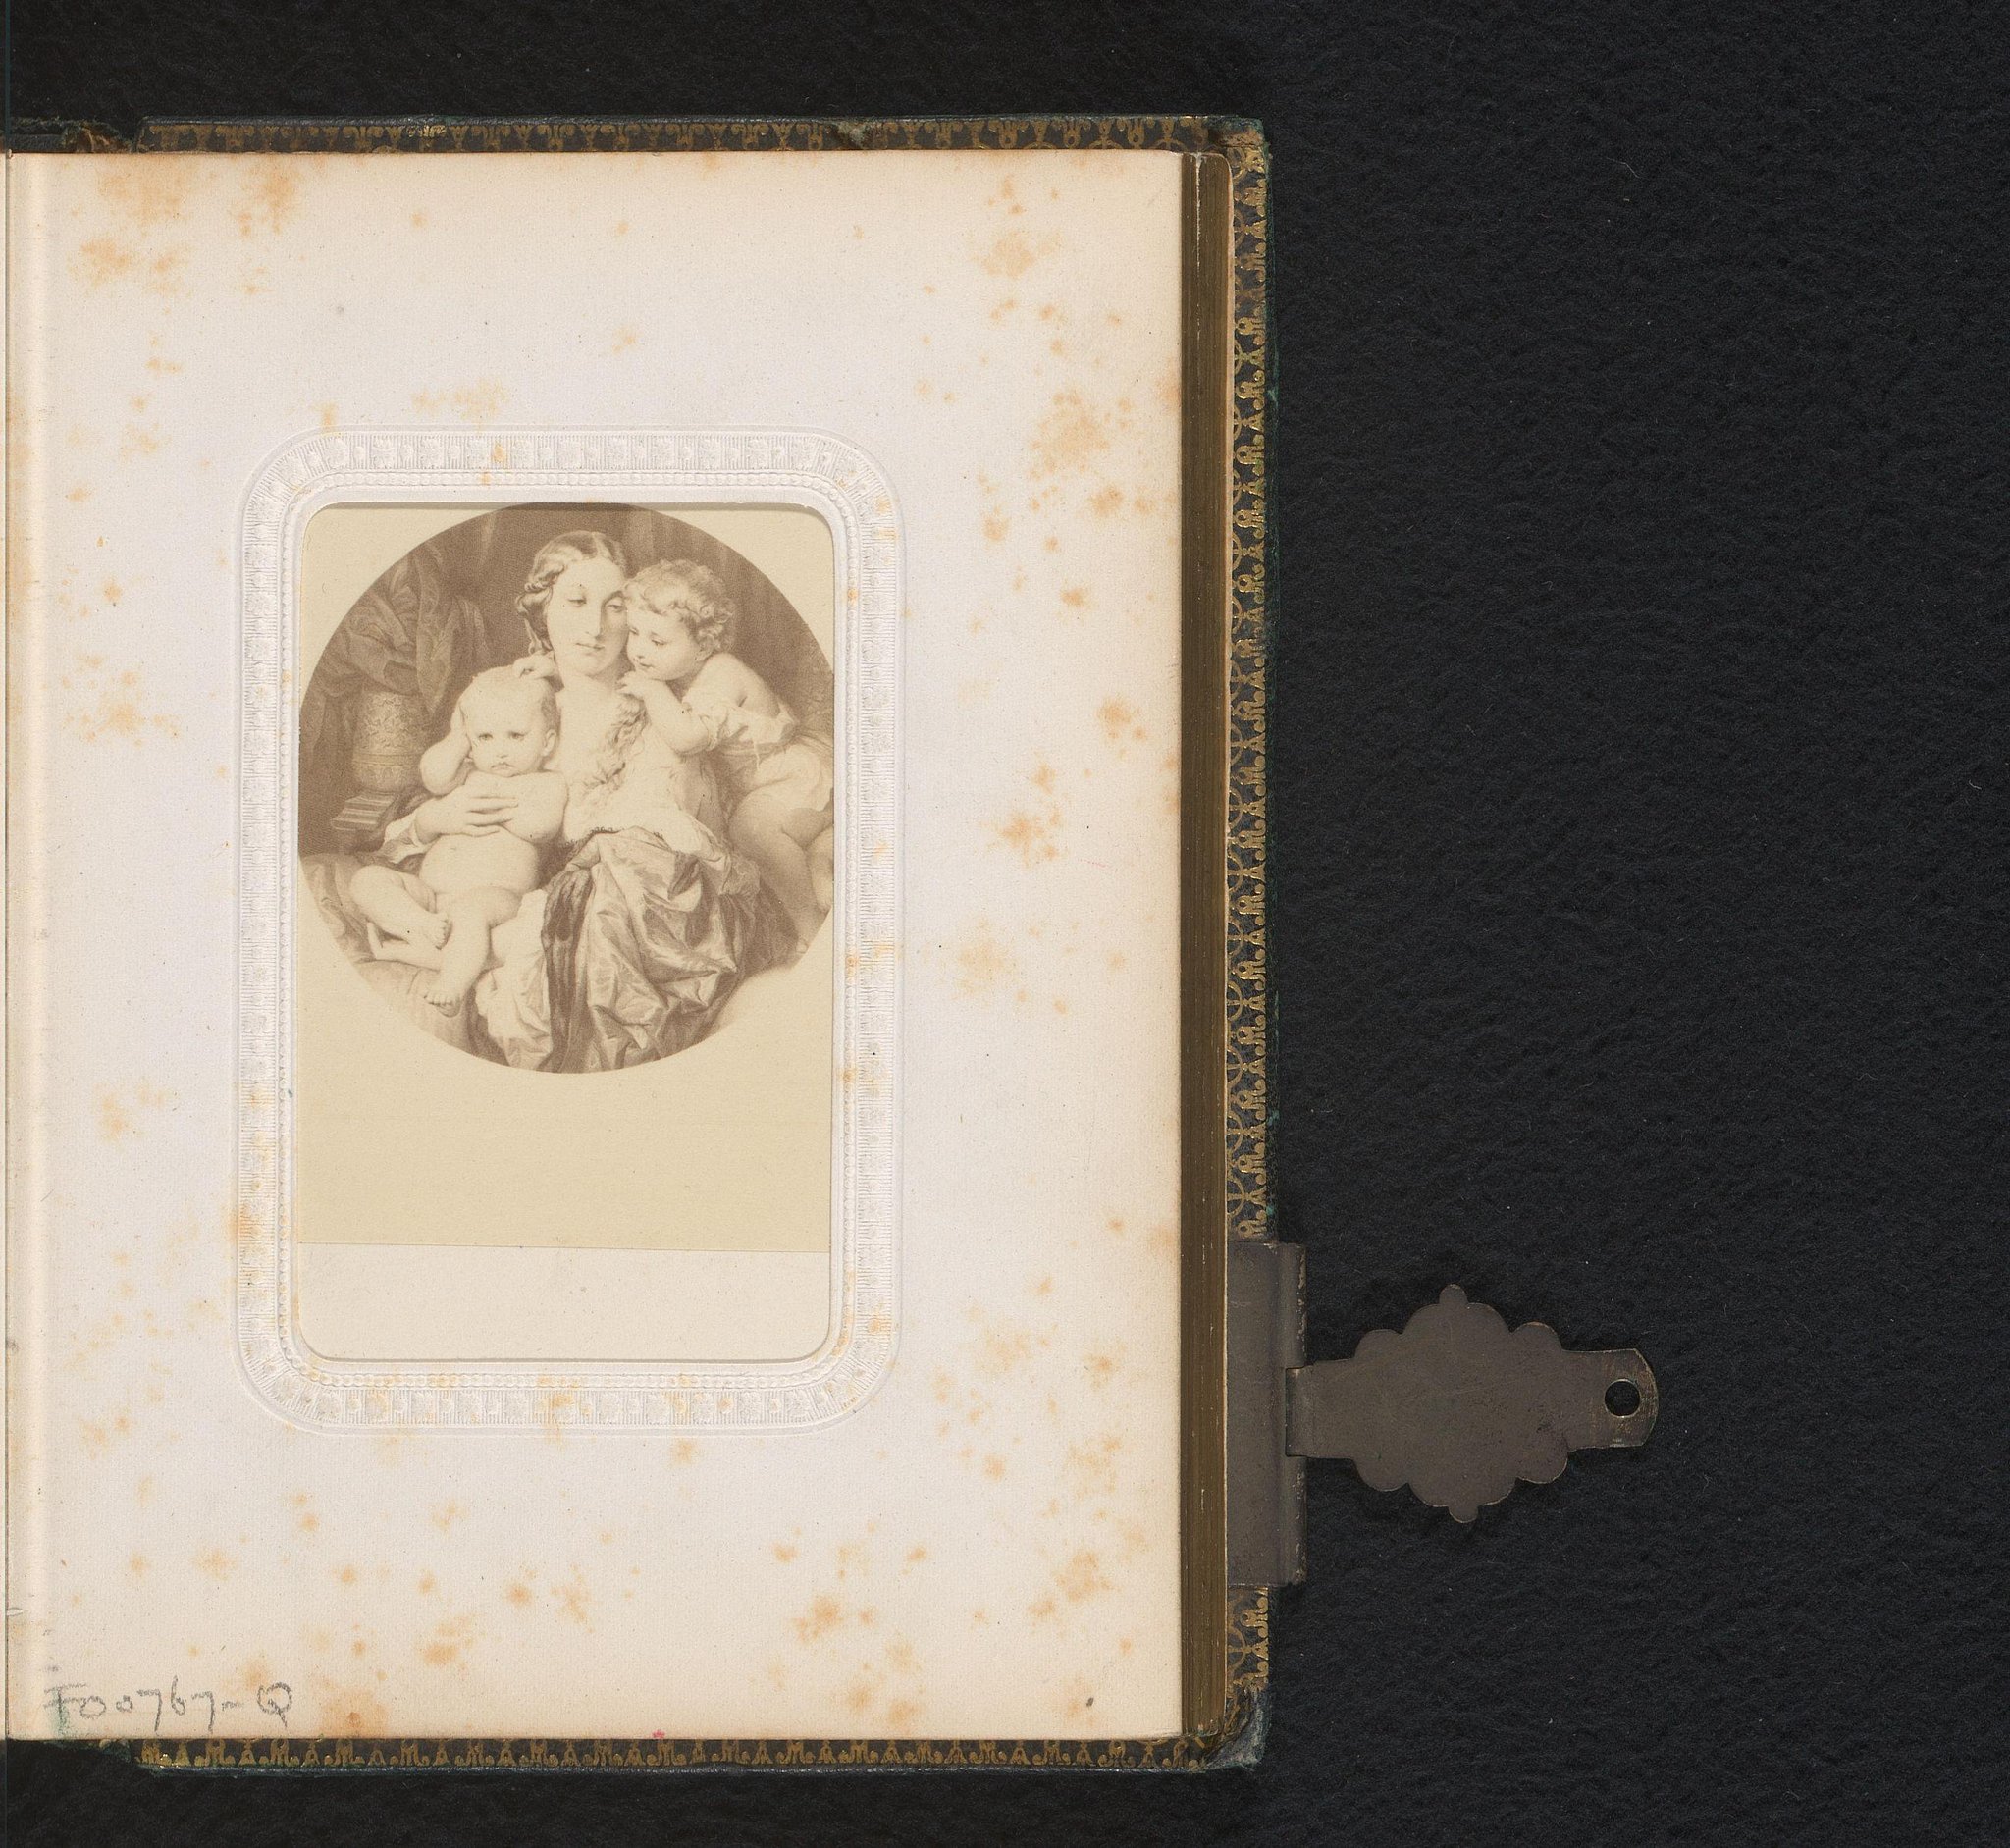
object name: reproduction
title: Fotoreproductie van een schilderij van een moeder met twee kinderen door Paul Delaroche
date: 1861-1878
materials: cardboard, photographic support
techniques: albumen print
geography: paris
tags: child (+ two persons), mother and child(ren), woman and child(ren) (family group)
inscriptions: inscription: ‘PHOTOGRAPHIE GOUPIL & Cie/ PARIS, 19, Bd Montmartre./ LONDRES-LA HAYE-BERLIN-NEW YORK’